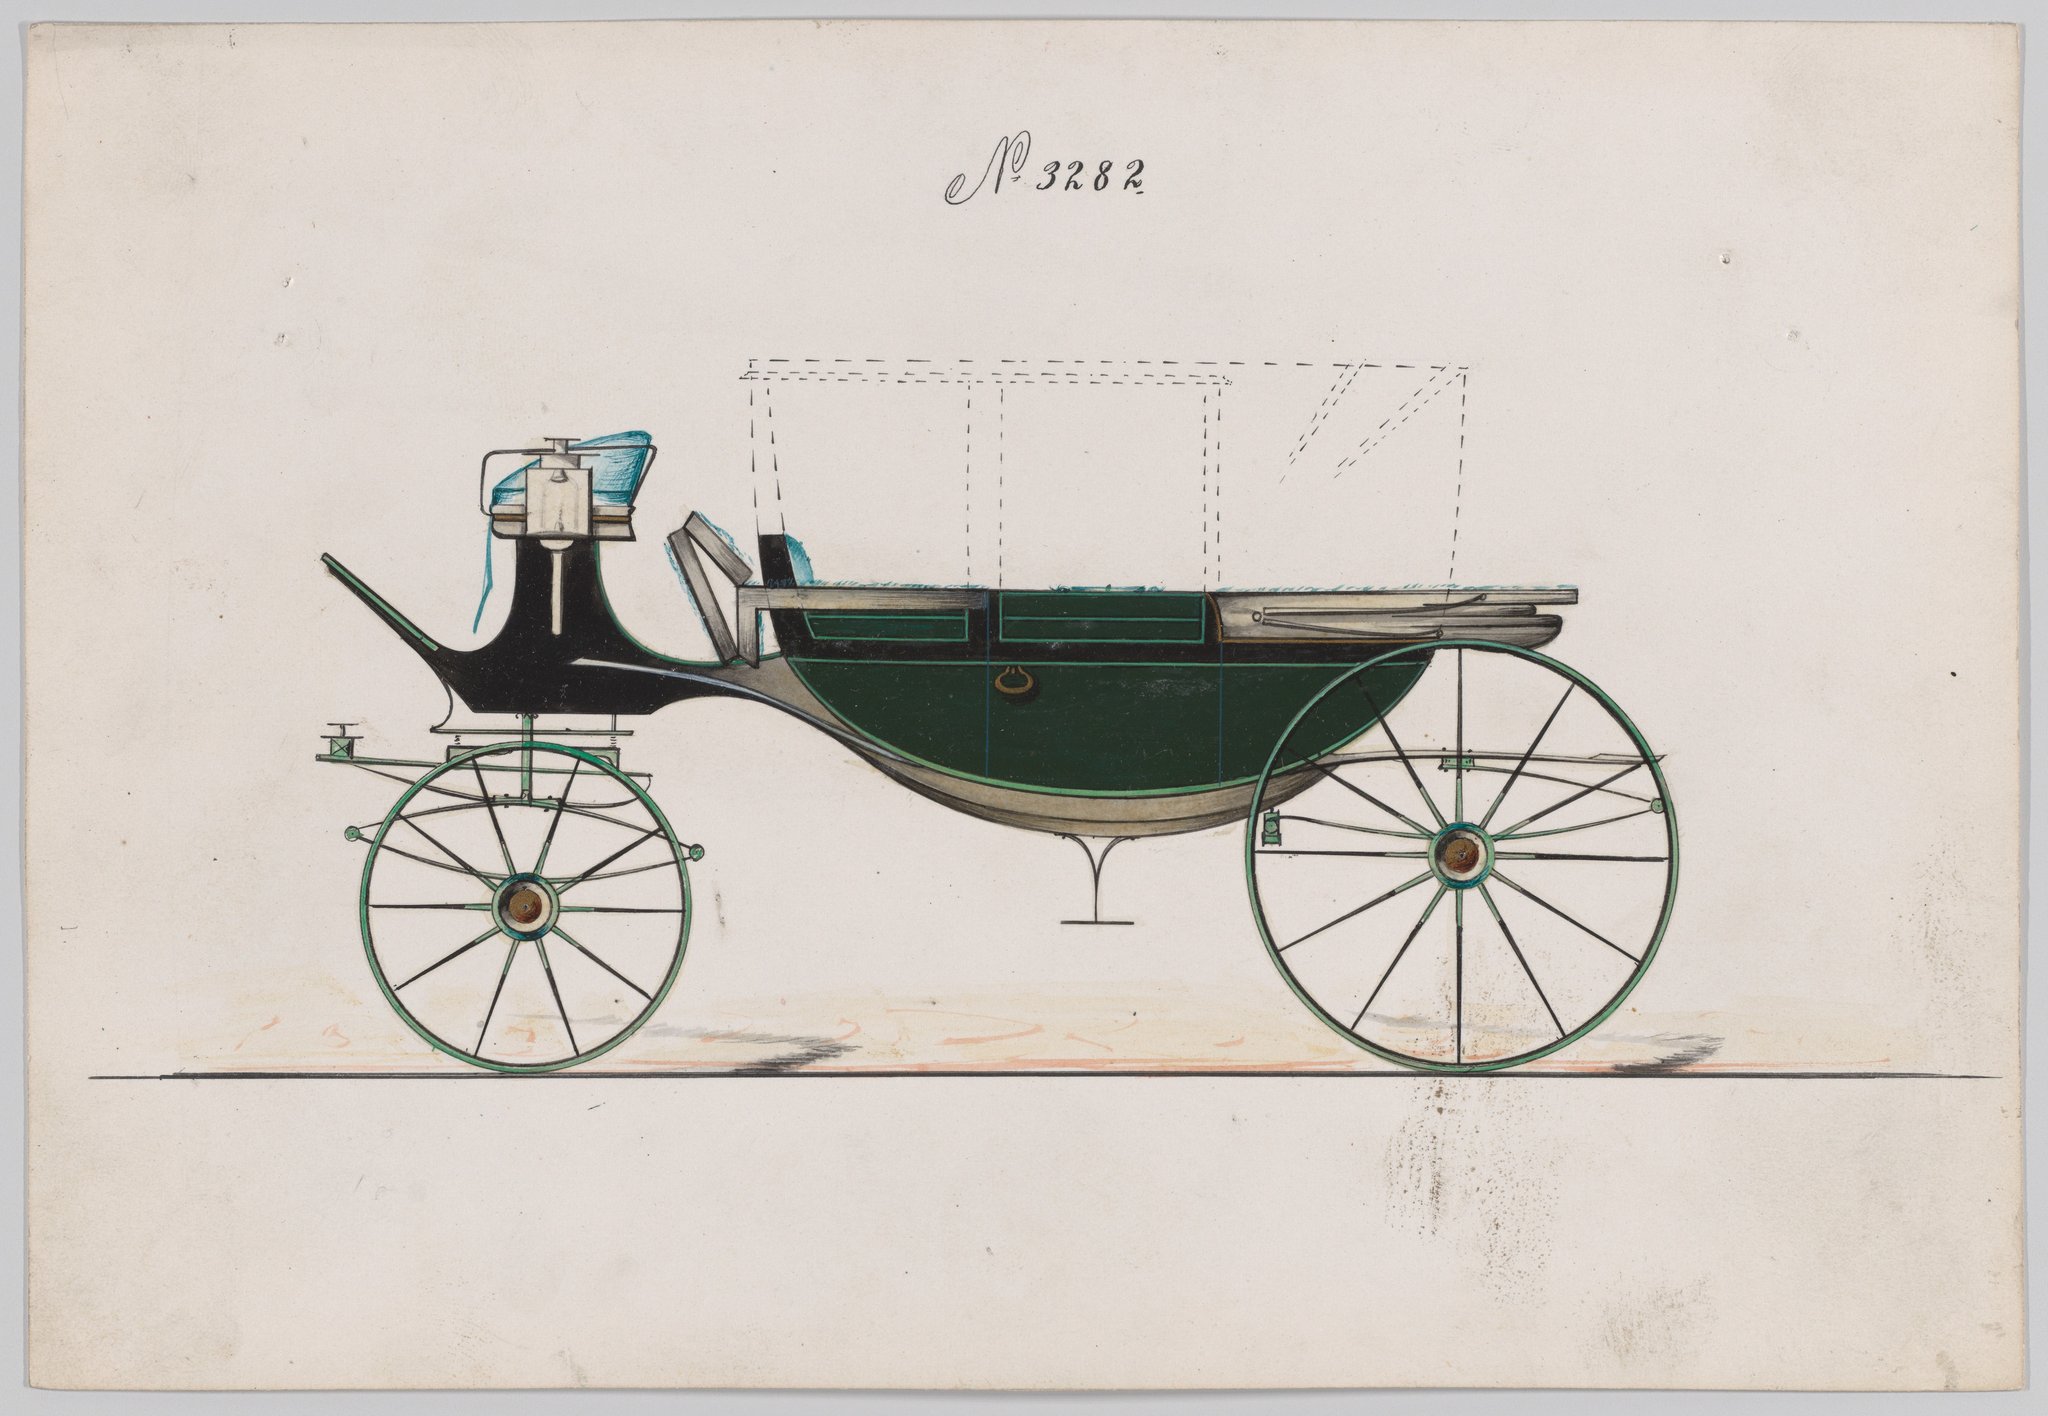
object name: drawing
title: Design for Landau, No. 3282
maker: brewster & co.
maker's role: manufacturer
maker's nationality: american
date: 1876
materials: gouache, gum arabic, ink, watercolor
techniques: pen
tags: carriages